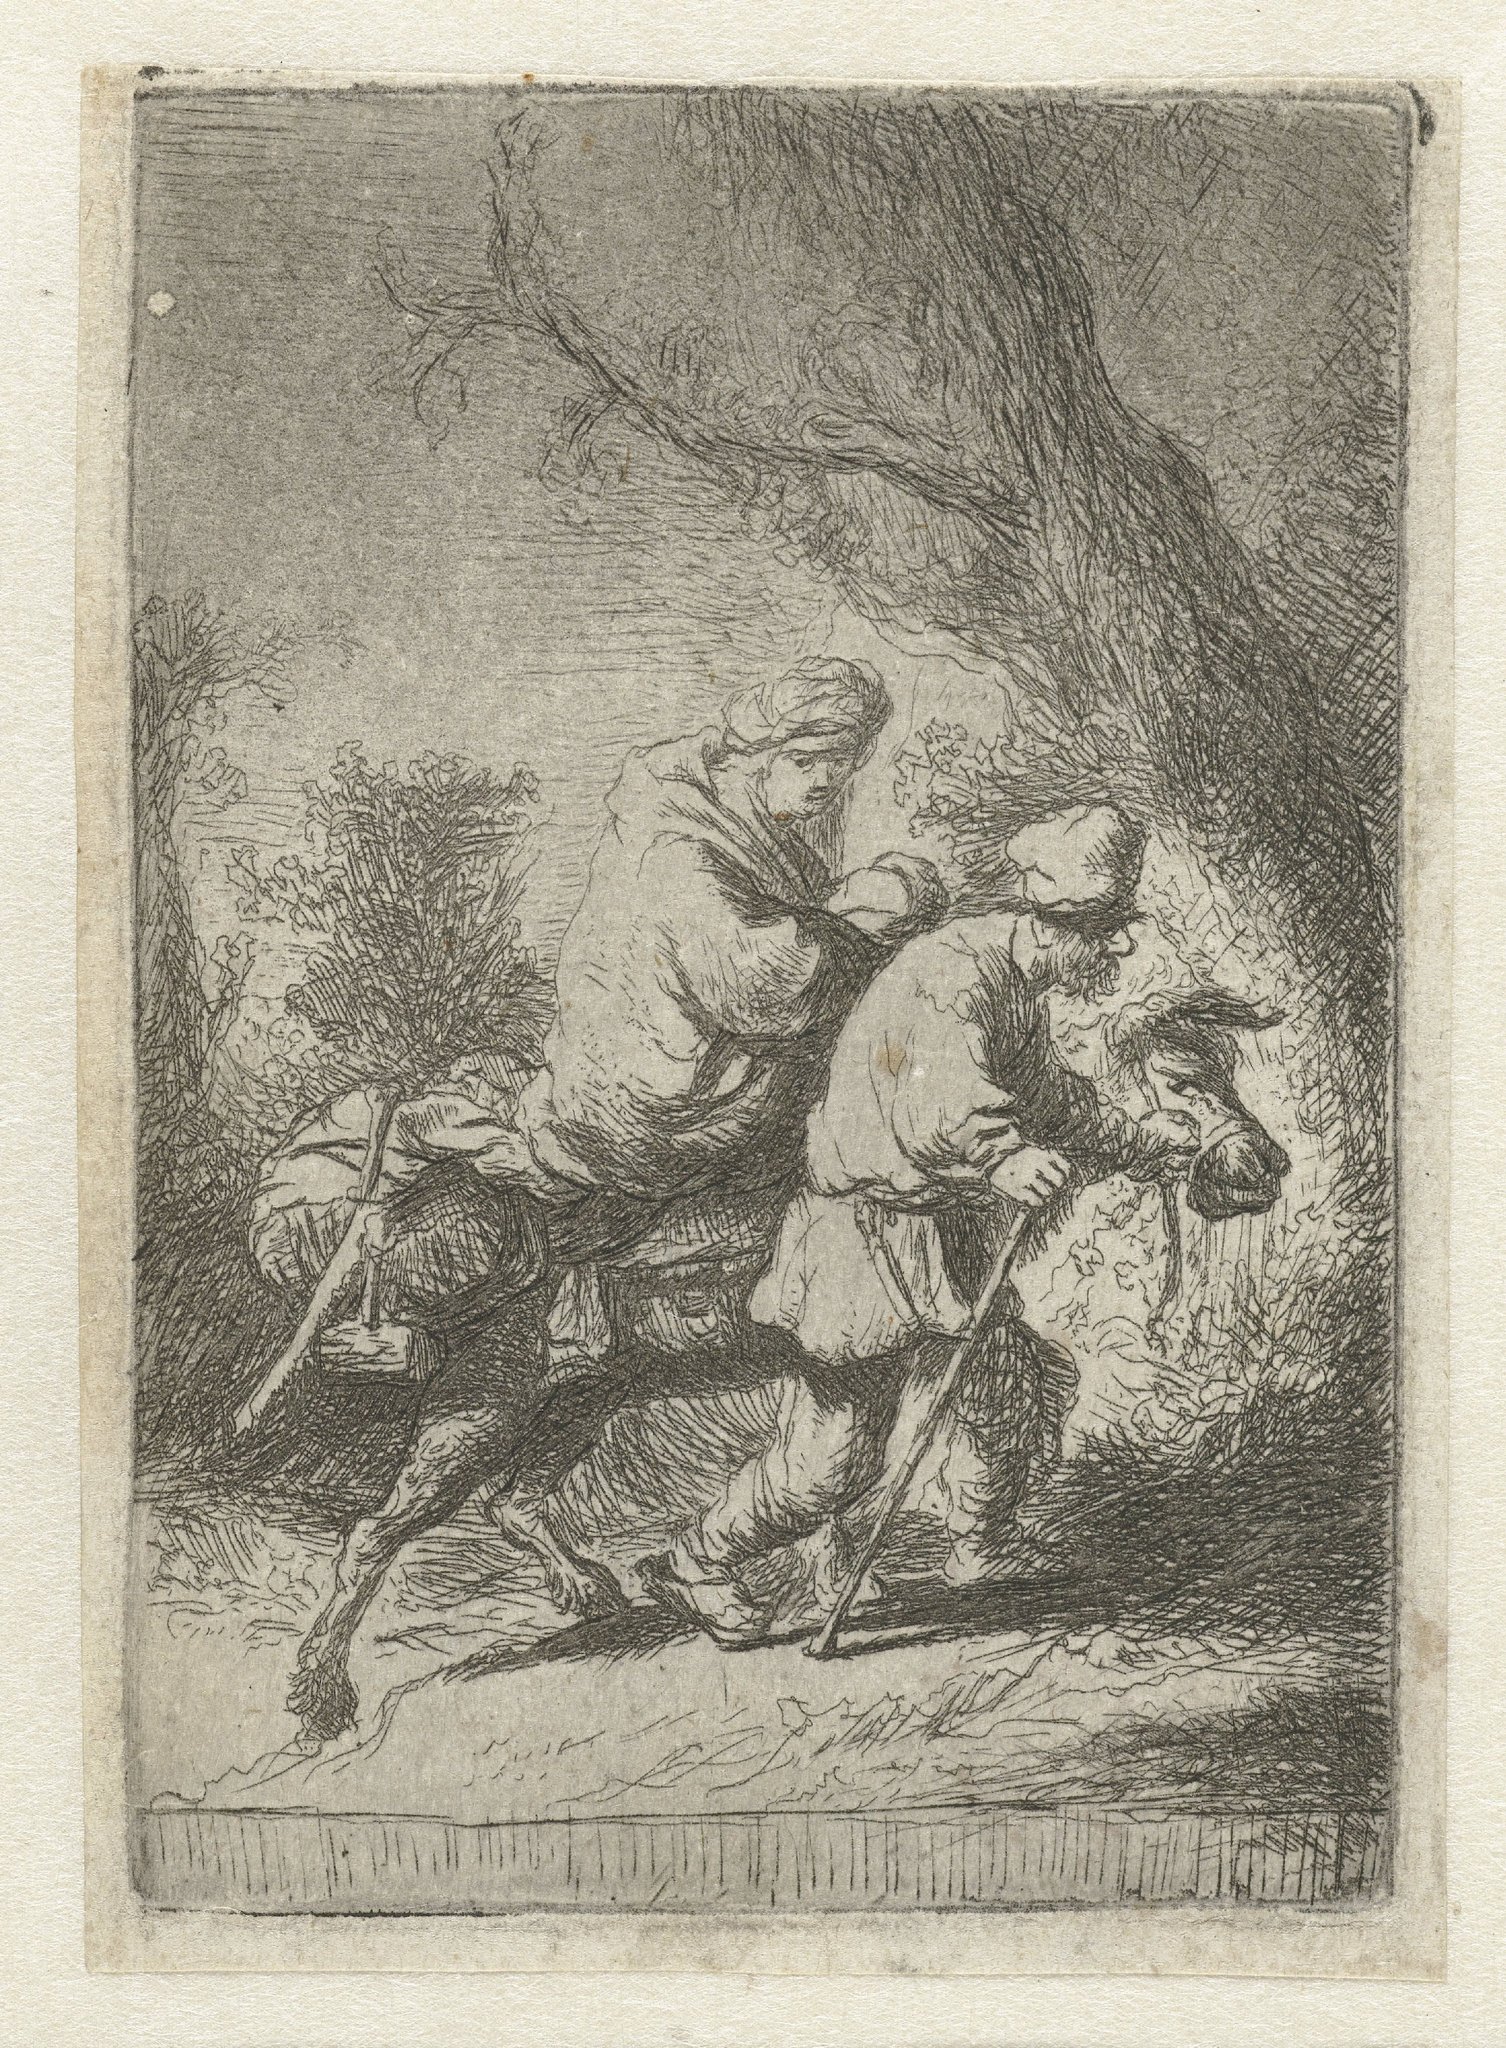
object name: print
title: The flight into Egypt: small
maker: Anonymous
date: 1633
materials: paper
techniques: etching, intaglio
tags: the flight into egypt: mary, joseph, the child (and sometimes others) on their way; mary usually riding on an ass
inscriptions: collector's mark: Lugt 240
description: Spiegelbeeldige kopie naar de gelijknamige prent van Rembrandt.